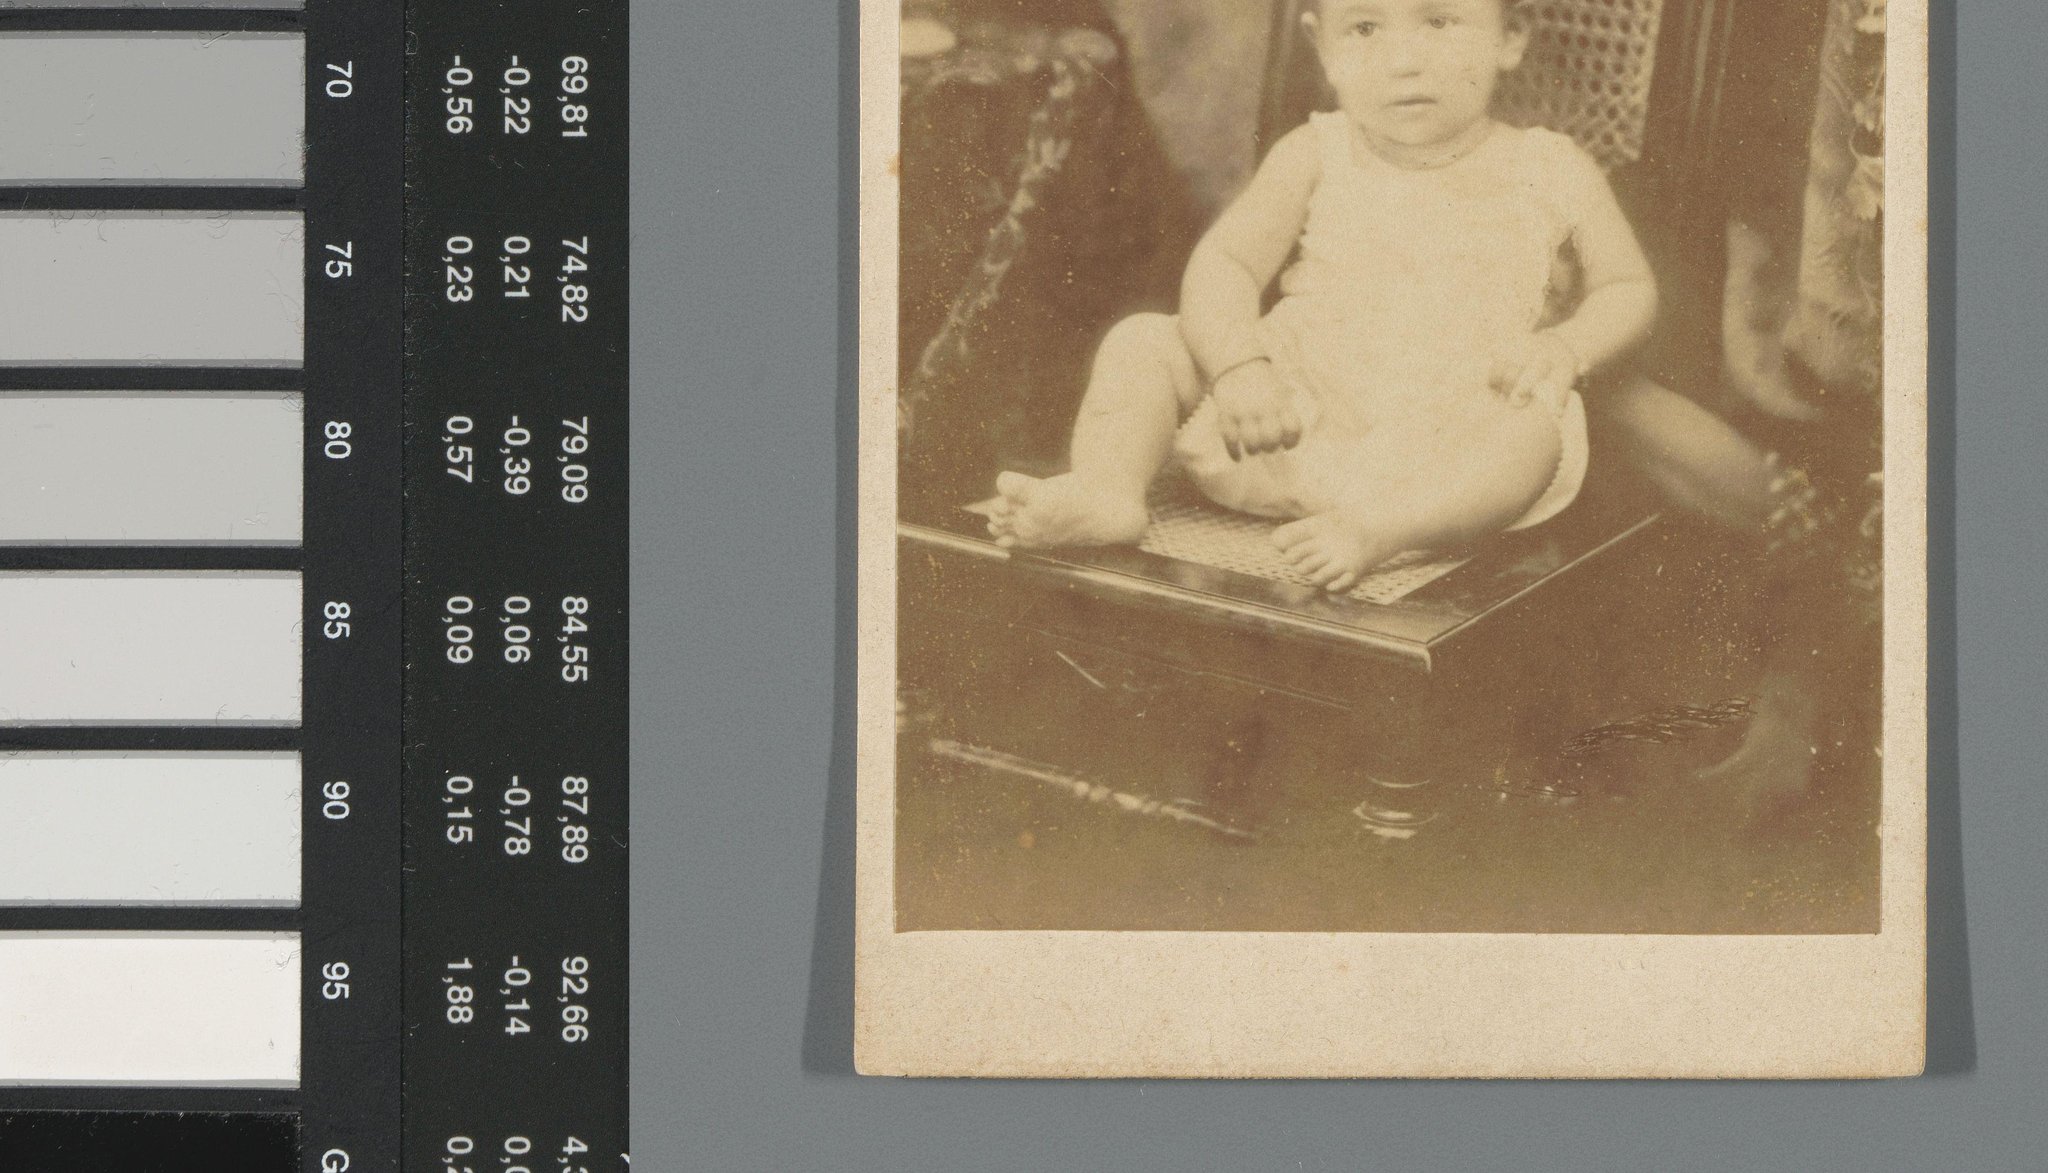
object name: photograph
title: Portret van Guusje Bruins als baby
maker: Anonymous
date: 1885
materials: cardboard, photographic support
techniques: albumen print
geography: dutch east indies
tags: java, historical persons - bb - woman, infant, baby, dutch east indies, the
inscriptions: inscription: ‘Guusje Bruins ?’